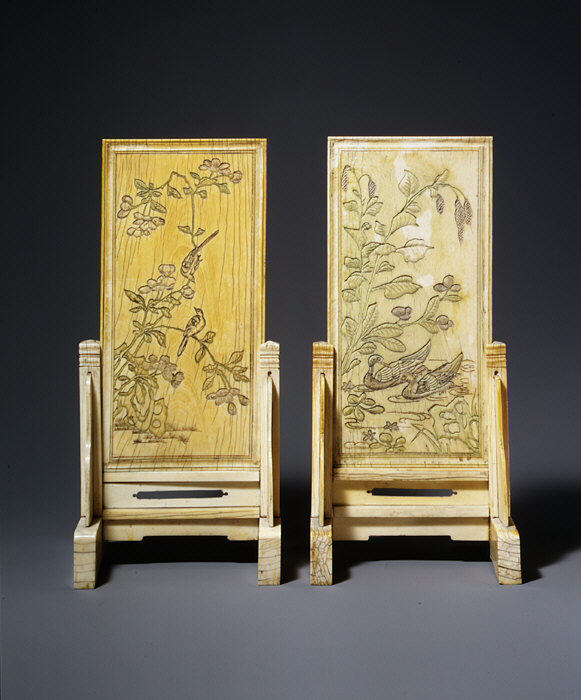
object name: table screen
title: Pair of table screens with flowers, birds, and poems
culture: chinese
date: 1601-1700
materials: ivory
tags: ducks,flowers